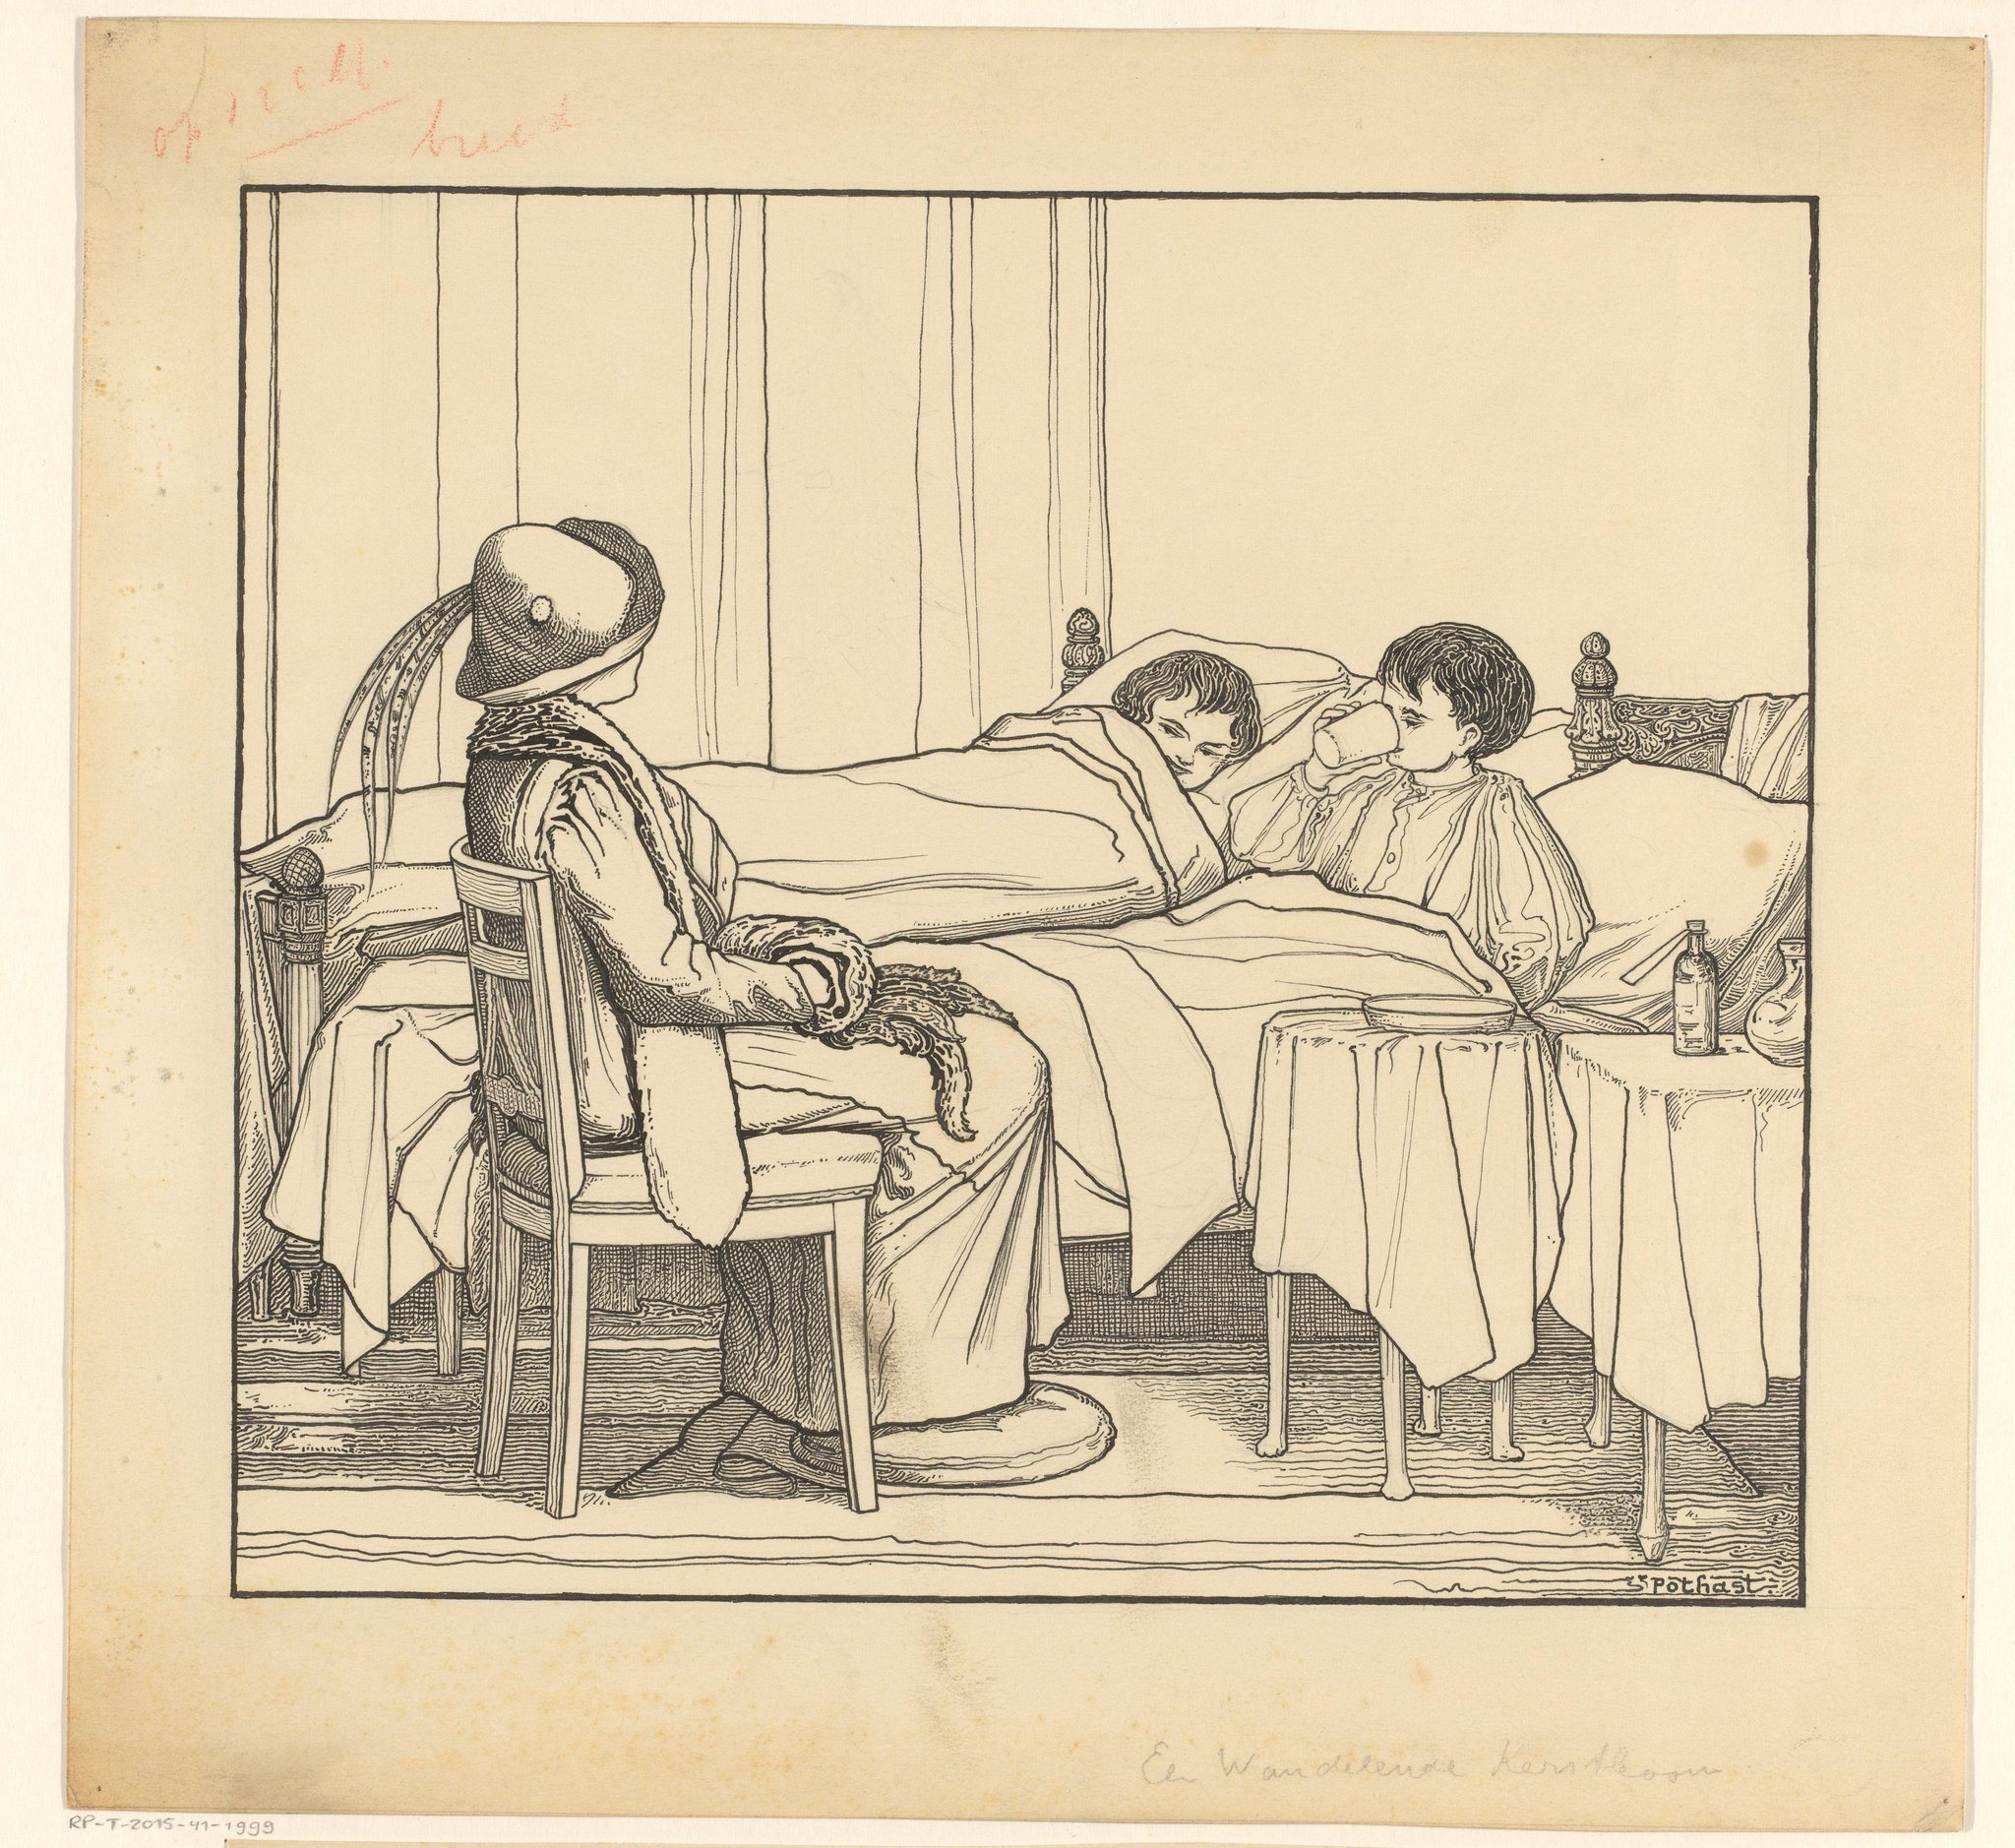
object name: drawing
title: Vrouw op ziekenbezoek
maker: willem pothast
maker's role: draughtsman, print maker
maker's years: 1877-1916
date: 1887-1916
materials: ink, paper, pencil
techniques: pen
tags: drinking, visiting the sick; sick person together with others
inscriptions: signature: ‘Pothast.’, :, annotation: ‘Een Wandelende kerstboom’, collector's mark: Lugt 2228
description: Een vrouw zit op een stoel naast de bedden van twee zieke kinderen. De vrouw draagt een hoed met veren en heeft haar handen in een mof gestoken. Eén van de kinderen drinkt uit een glas.